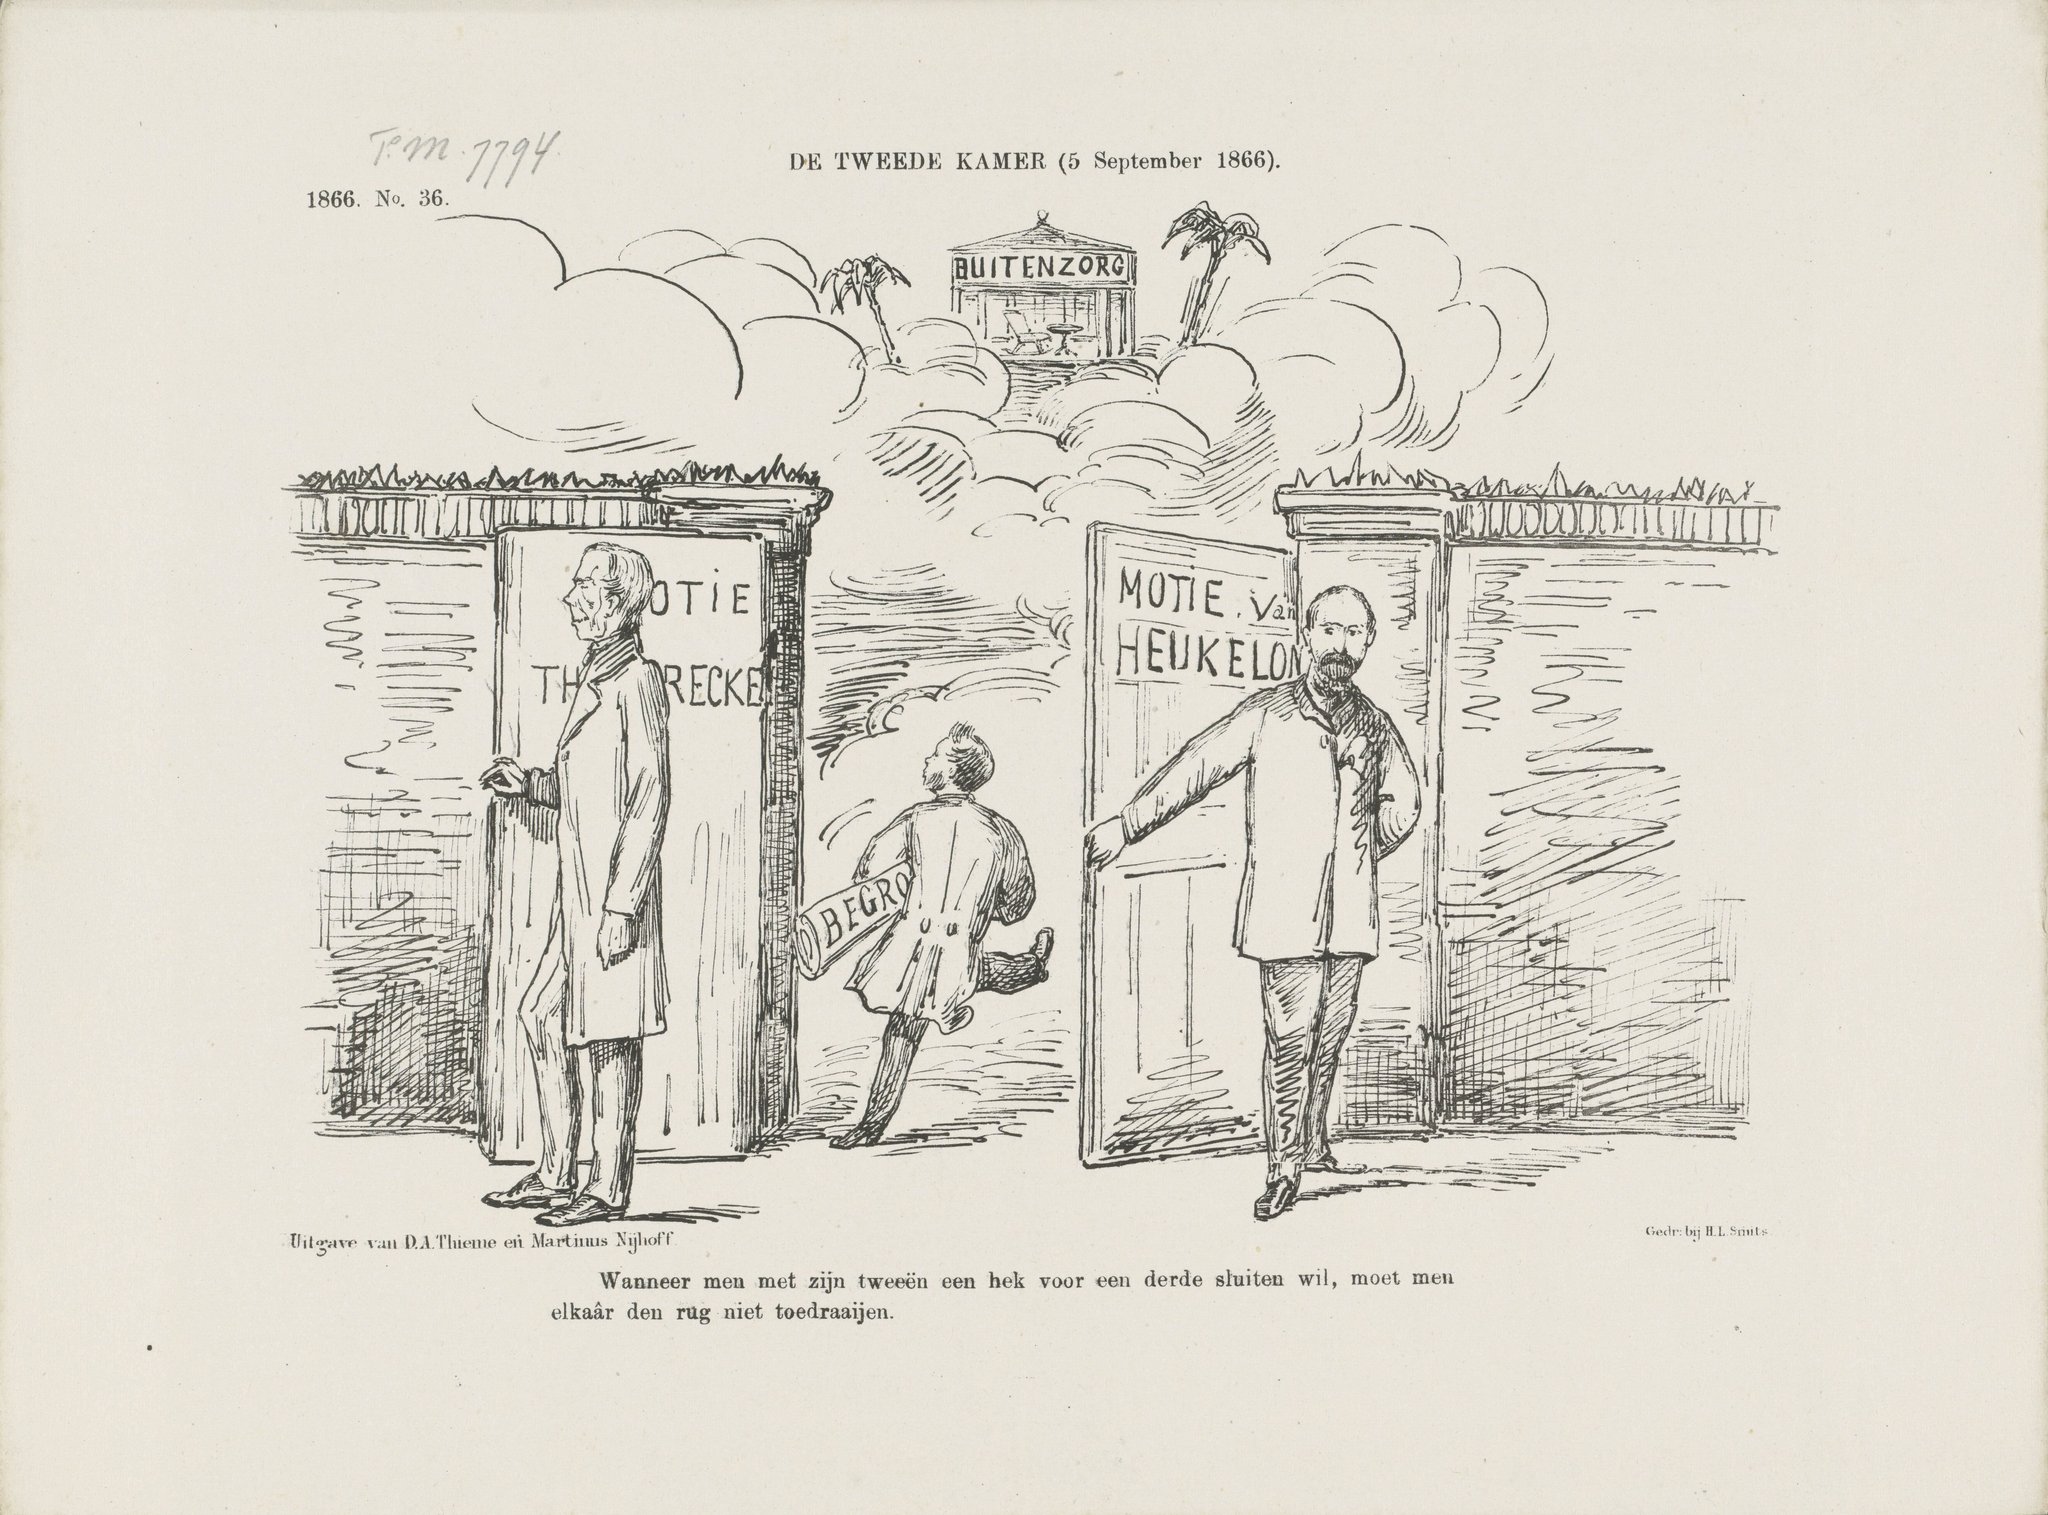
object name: cartoon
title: In de Tweede Kamer (5 September 1866)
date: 1866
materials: paper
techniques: lithograph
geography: netherlands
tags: the hague, johan rudolf thorbecke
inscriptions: collector's mark: Lugt 2228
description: Spotprent waarin Thorbecke en Van Heukelom proberen de deuren te sluiten maar Mijer er met zijn begroting tussendoor glipt. Op de achtergrond Buitenzorg. Plaat verschenen bij het weekblad De Nederlandsche Spectator, nr. 36, 8 september 1866.